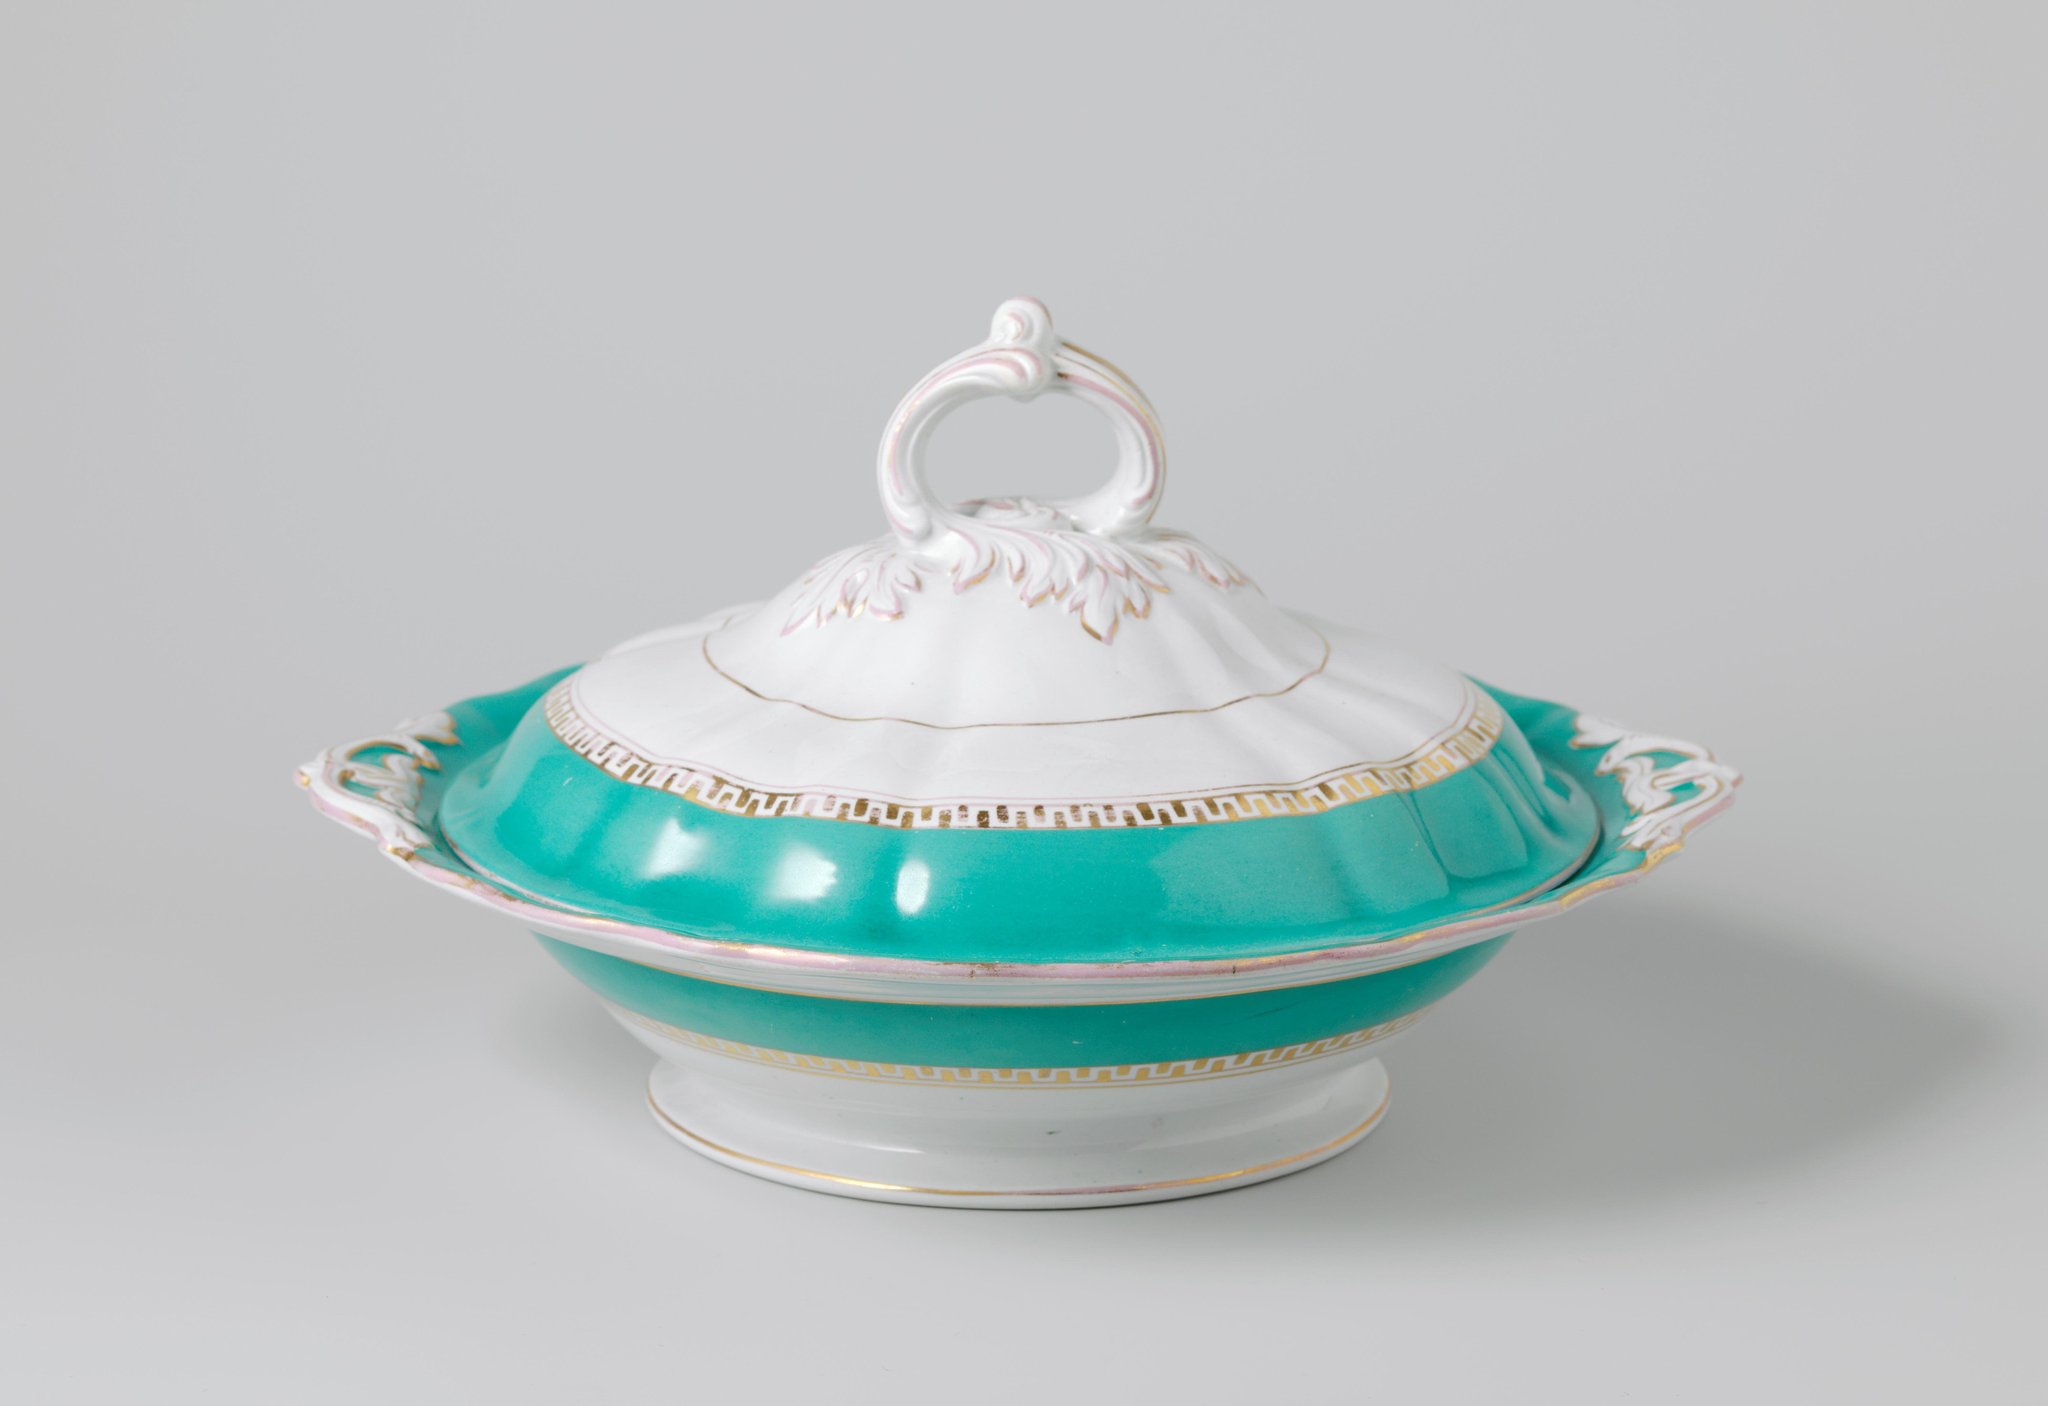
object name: aiguillère, dekschaal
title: Dekschaal, rond, met groene rand en gouden Griekse band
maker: petrus regout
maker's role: plateelbakker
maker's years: 1801-1879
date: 1865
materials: earthenware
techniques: transfer decoration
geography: maastricht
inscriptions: check stamp: ‘P. REGOUT // 1 // MAASTRICHT 20’, check stamp: ‘14’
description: Dekschaal van aardewerk, rond, geschulpt, met groene rand en gouden Griekse band.